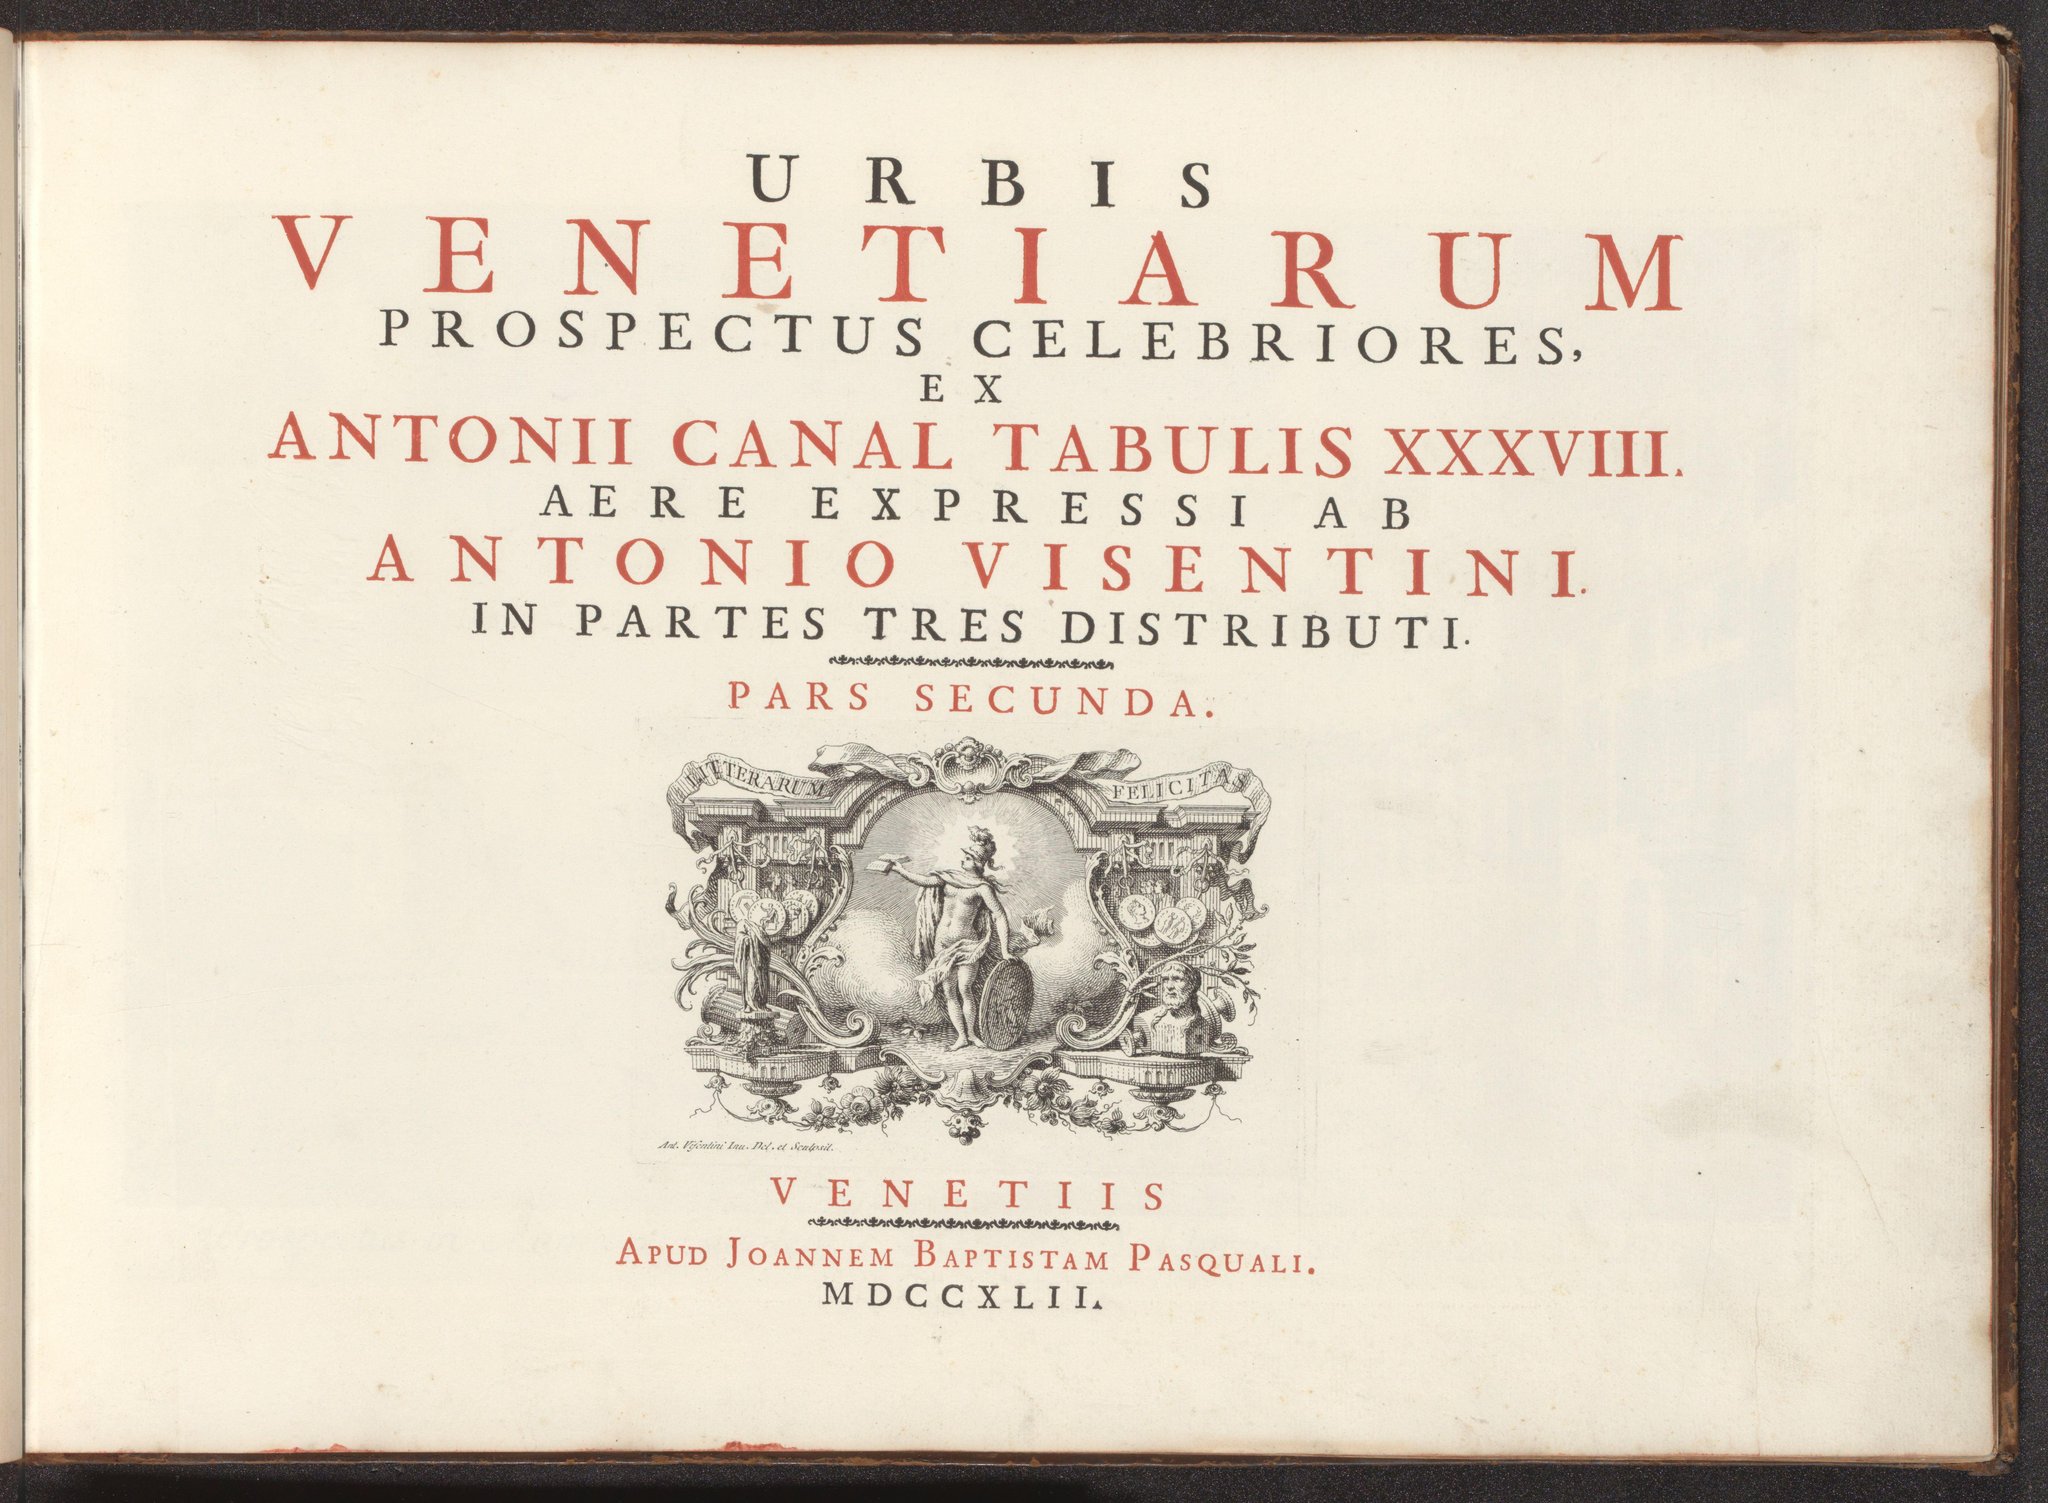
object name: titelprent, frontispice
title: Urbis Venetiarum prospectus celebriores, ex Antonii Canal tabulis XXXVIII aere expressi ab Antonio Vissentini in partes tres distributi. pars secunda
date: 1742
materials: paper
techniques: etching, letterpress printing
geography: venice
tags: abstract ideas and concepts (+ abstract concept represented by female figure), ornament ~ cartouche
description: Een cartouche met een naakte vrouwenfiguur met schild, helm en boek. Boven een banderol met de tekst: Literarum Felicitas. De prent maakt deel uit van een album.